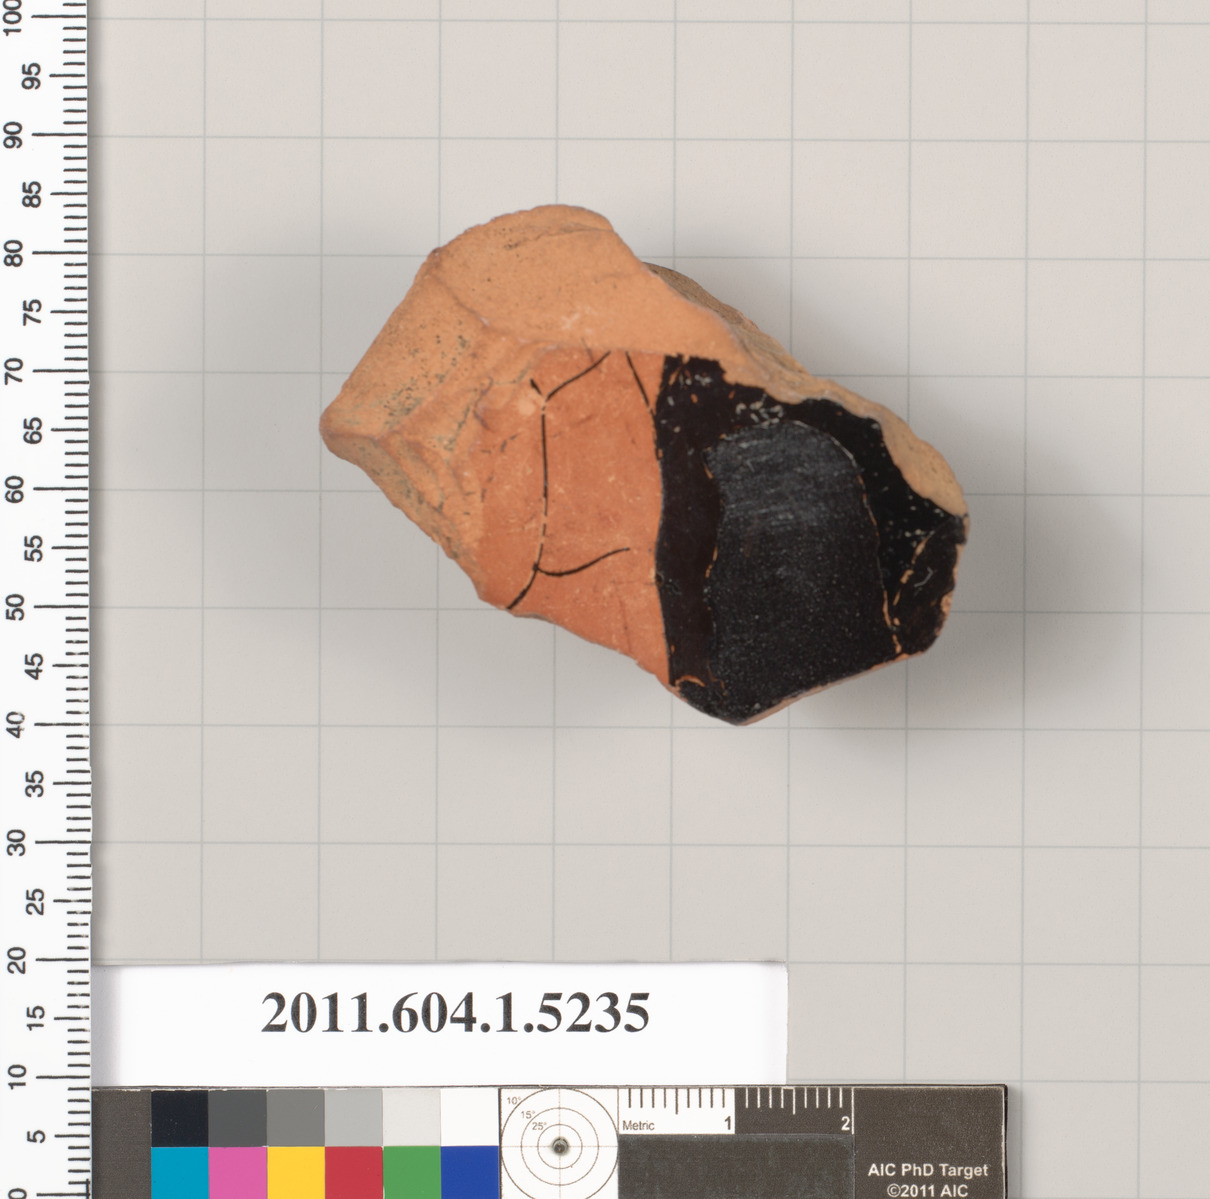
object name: kylix fragment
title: Terracotta fragment of a kylix (drinking cup)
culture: greek, attic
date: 500-480 BCE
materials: terracotta